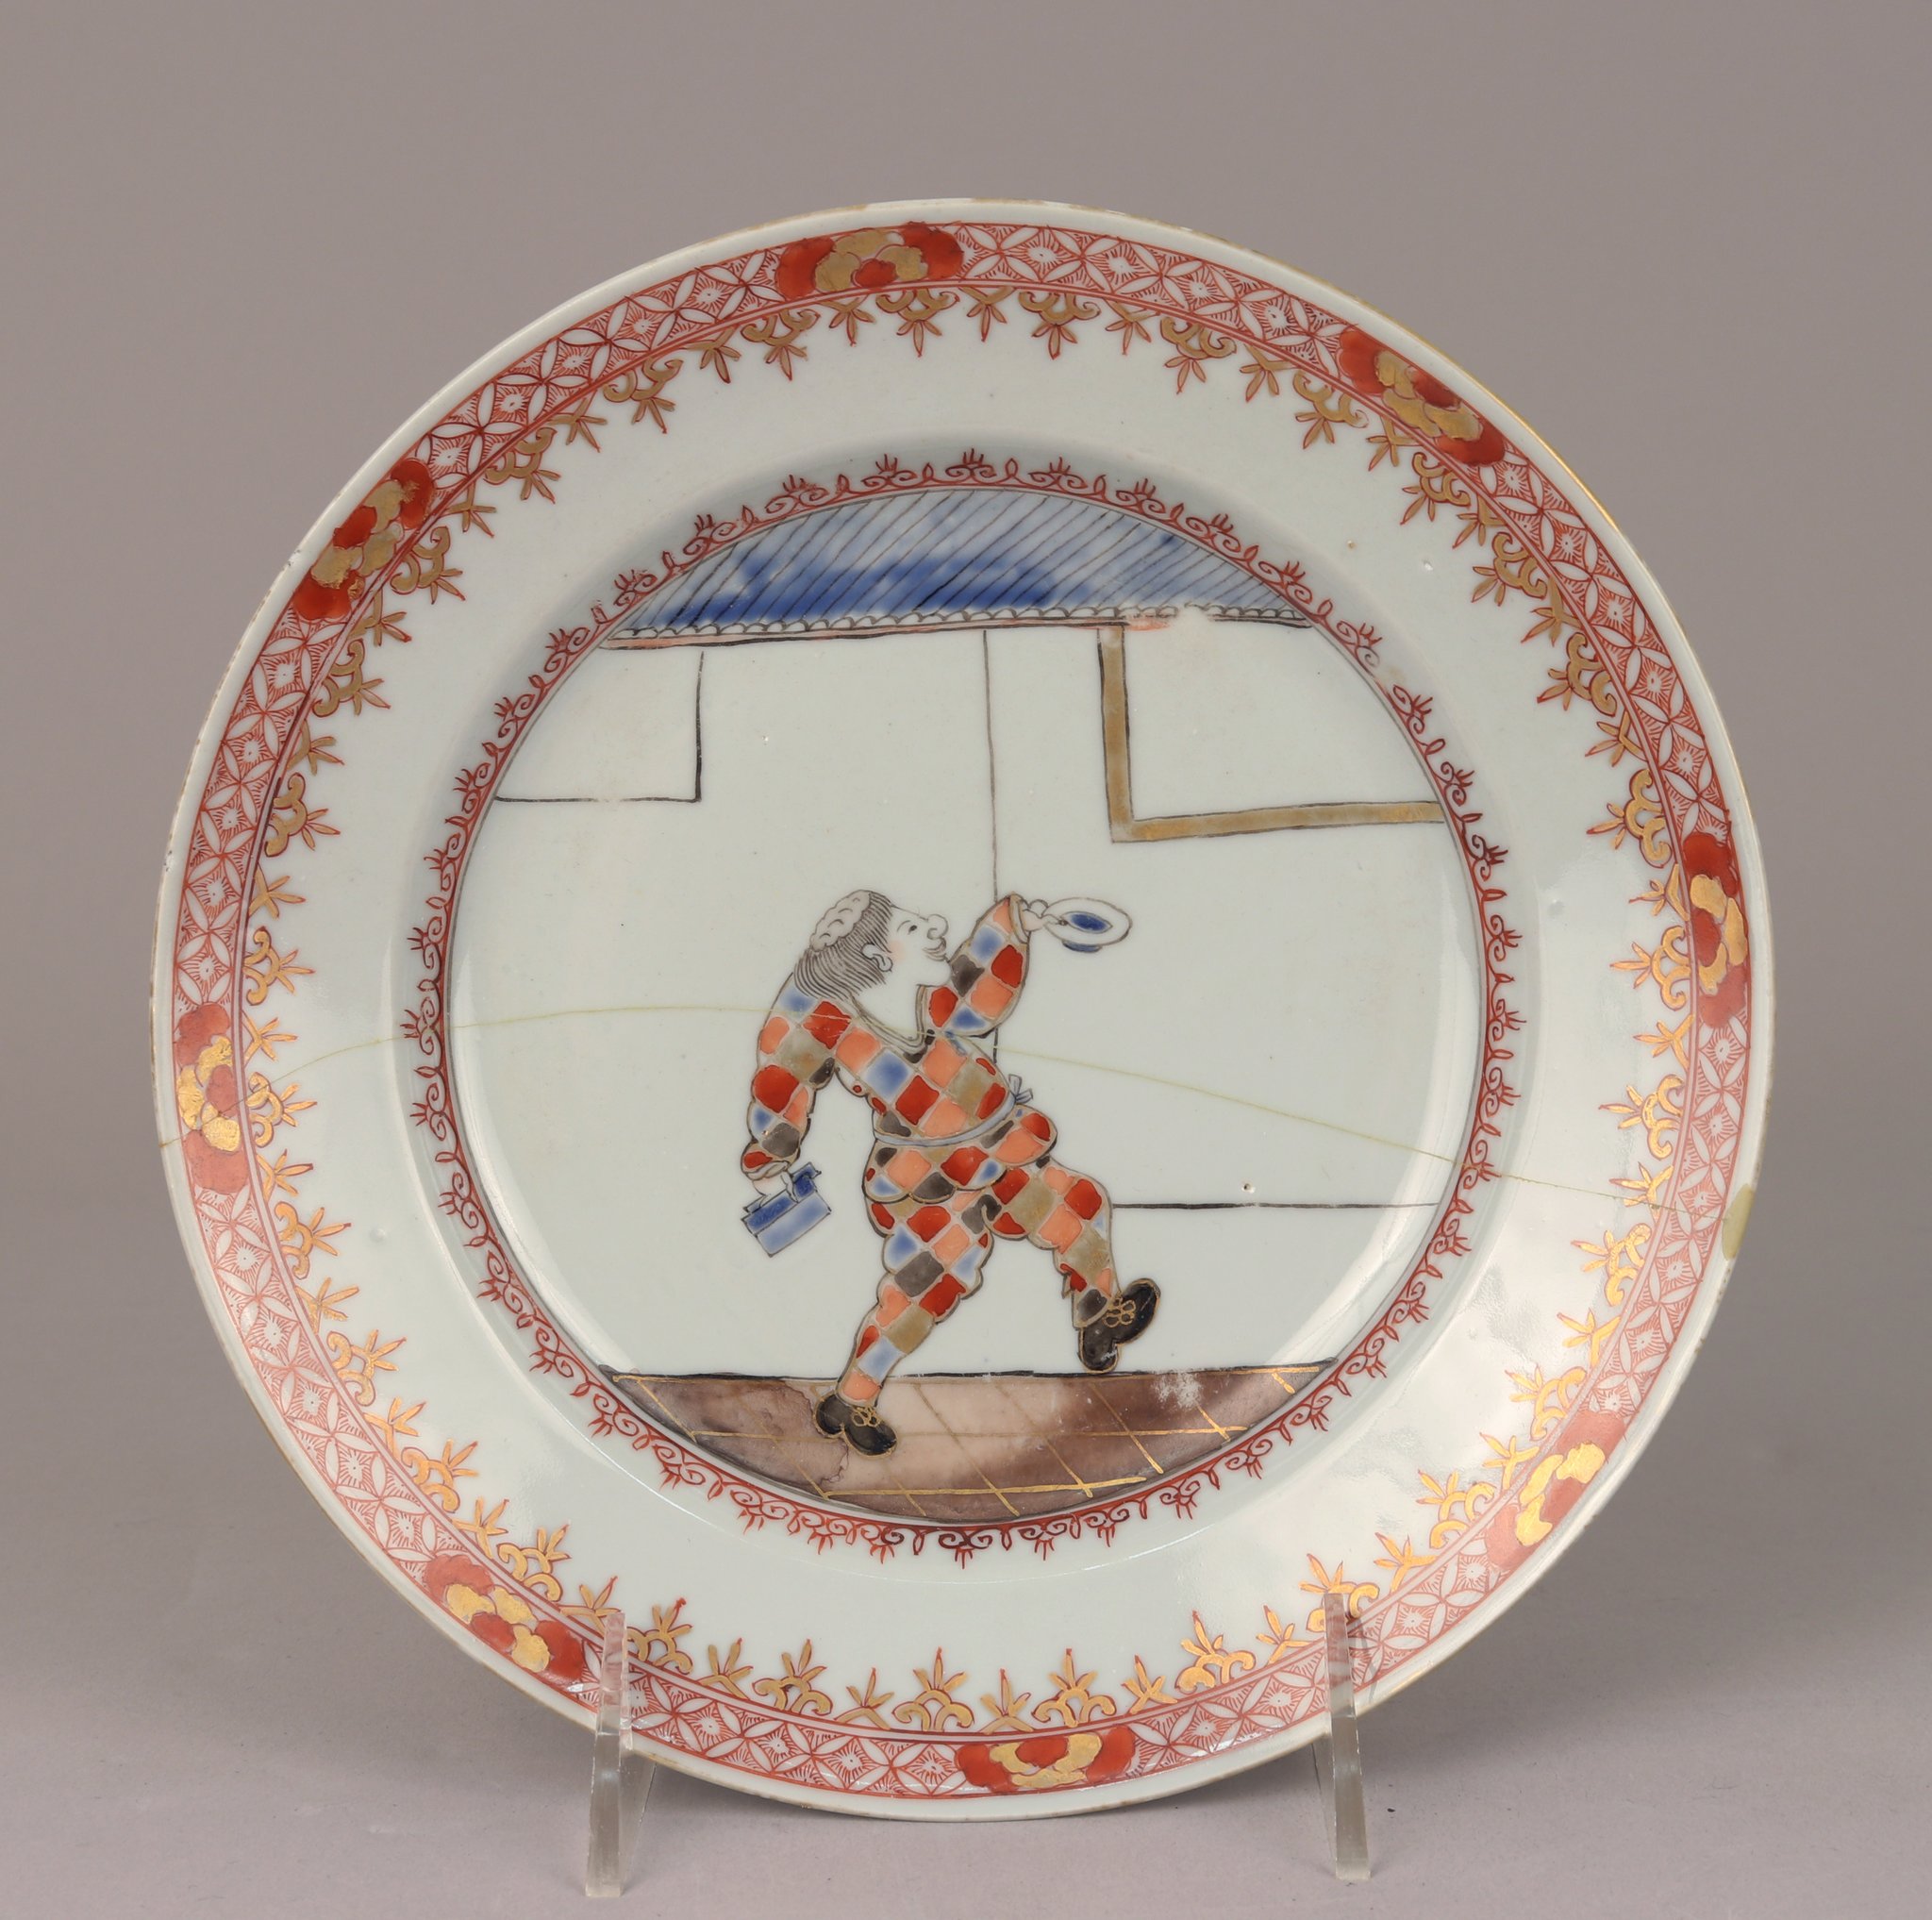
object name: plate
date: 1720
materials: hard paste porcelain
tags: men